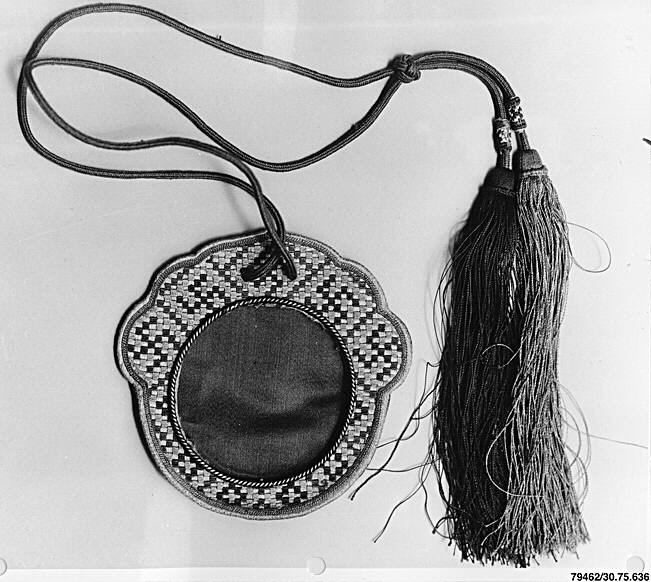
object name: mirror case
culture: chinese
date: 1701-1900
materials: metal, silk